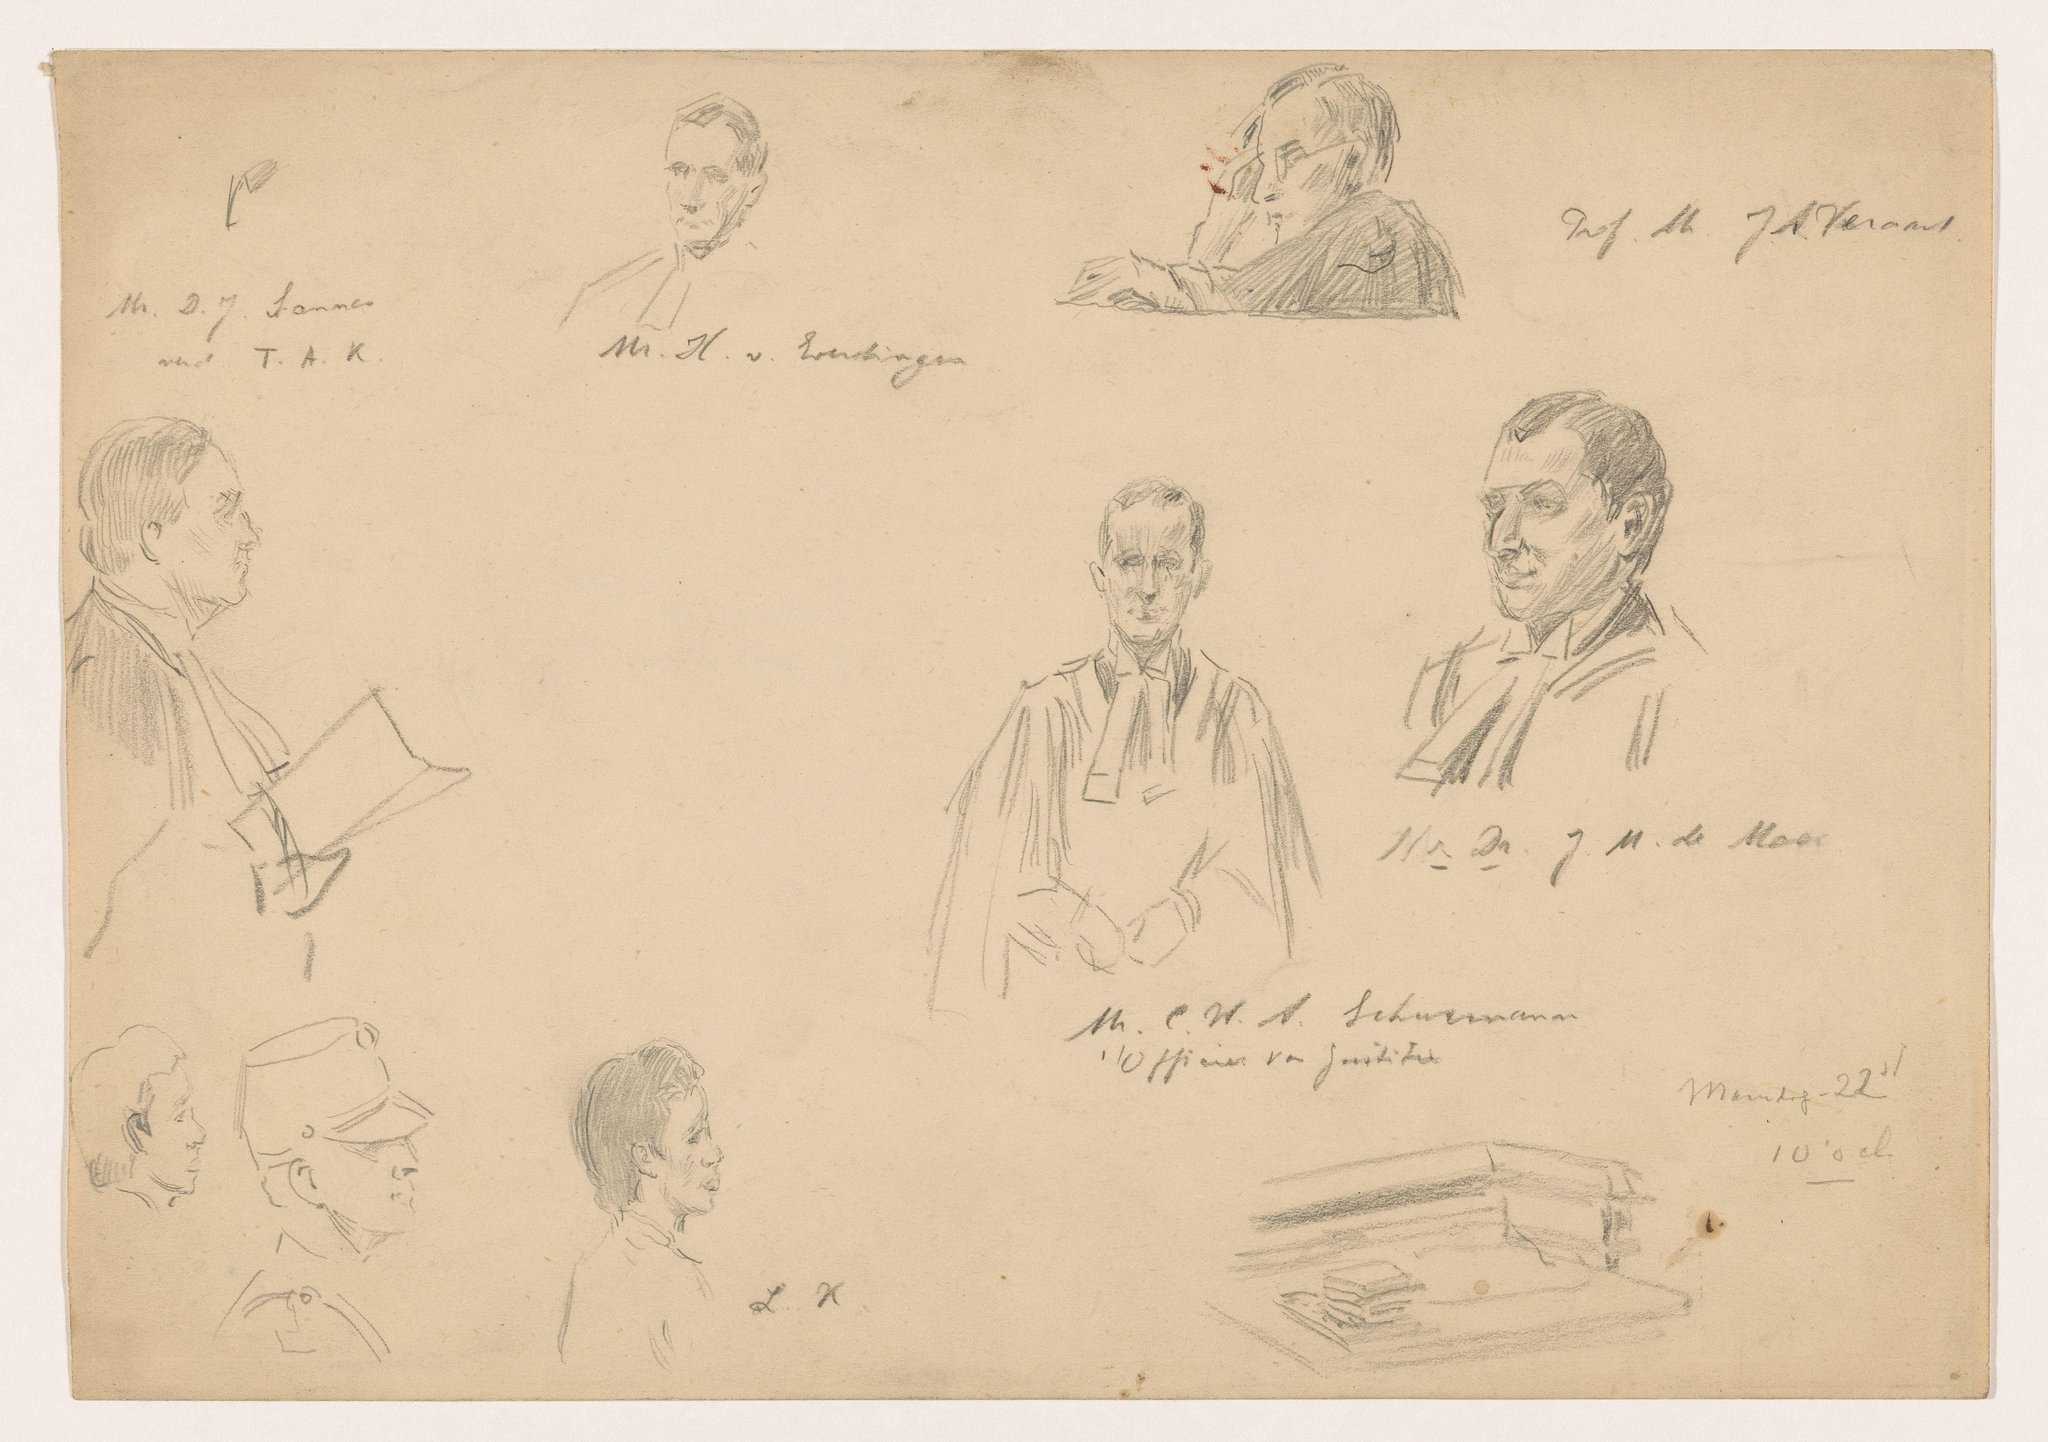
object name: drawing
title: Portretstudies voor het (onvoltooide) schilderij van de Nederlandse rechtbank in Londen, juni 1942: de twee Chinese verdachten en leden van de rechtbank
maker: anton abraham van anrooy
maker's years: 1870-1949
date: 1942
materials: paper, pencil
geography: westminster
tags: anton abraham van anrooy, historical persons, london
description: Schets van twee Chinese verdachten en leden van de Nederlandse rechtbank tijdens een zitting in Londen op 22 juni 1942. Anton van Anrooy, 1942 Links de advocaat Mr. D.J. Sannes, linksonder een wachter en de twee verdachten T.A.K. en L.K., rechtsboven Mr. H. van Everdingen en Prof. Mr. J.A. Veraart, daaronder de waarnemend officier van justitie Mr. C.W.A. Schürmann en rechts daarvan de voorzitter Mr. J.M. de Moor.